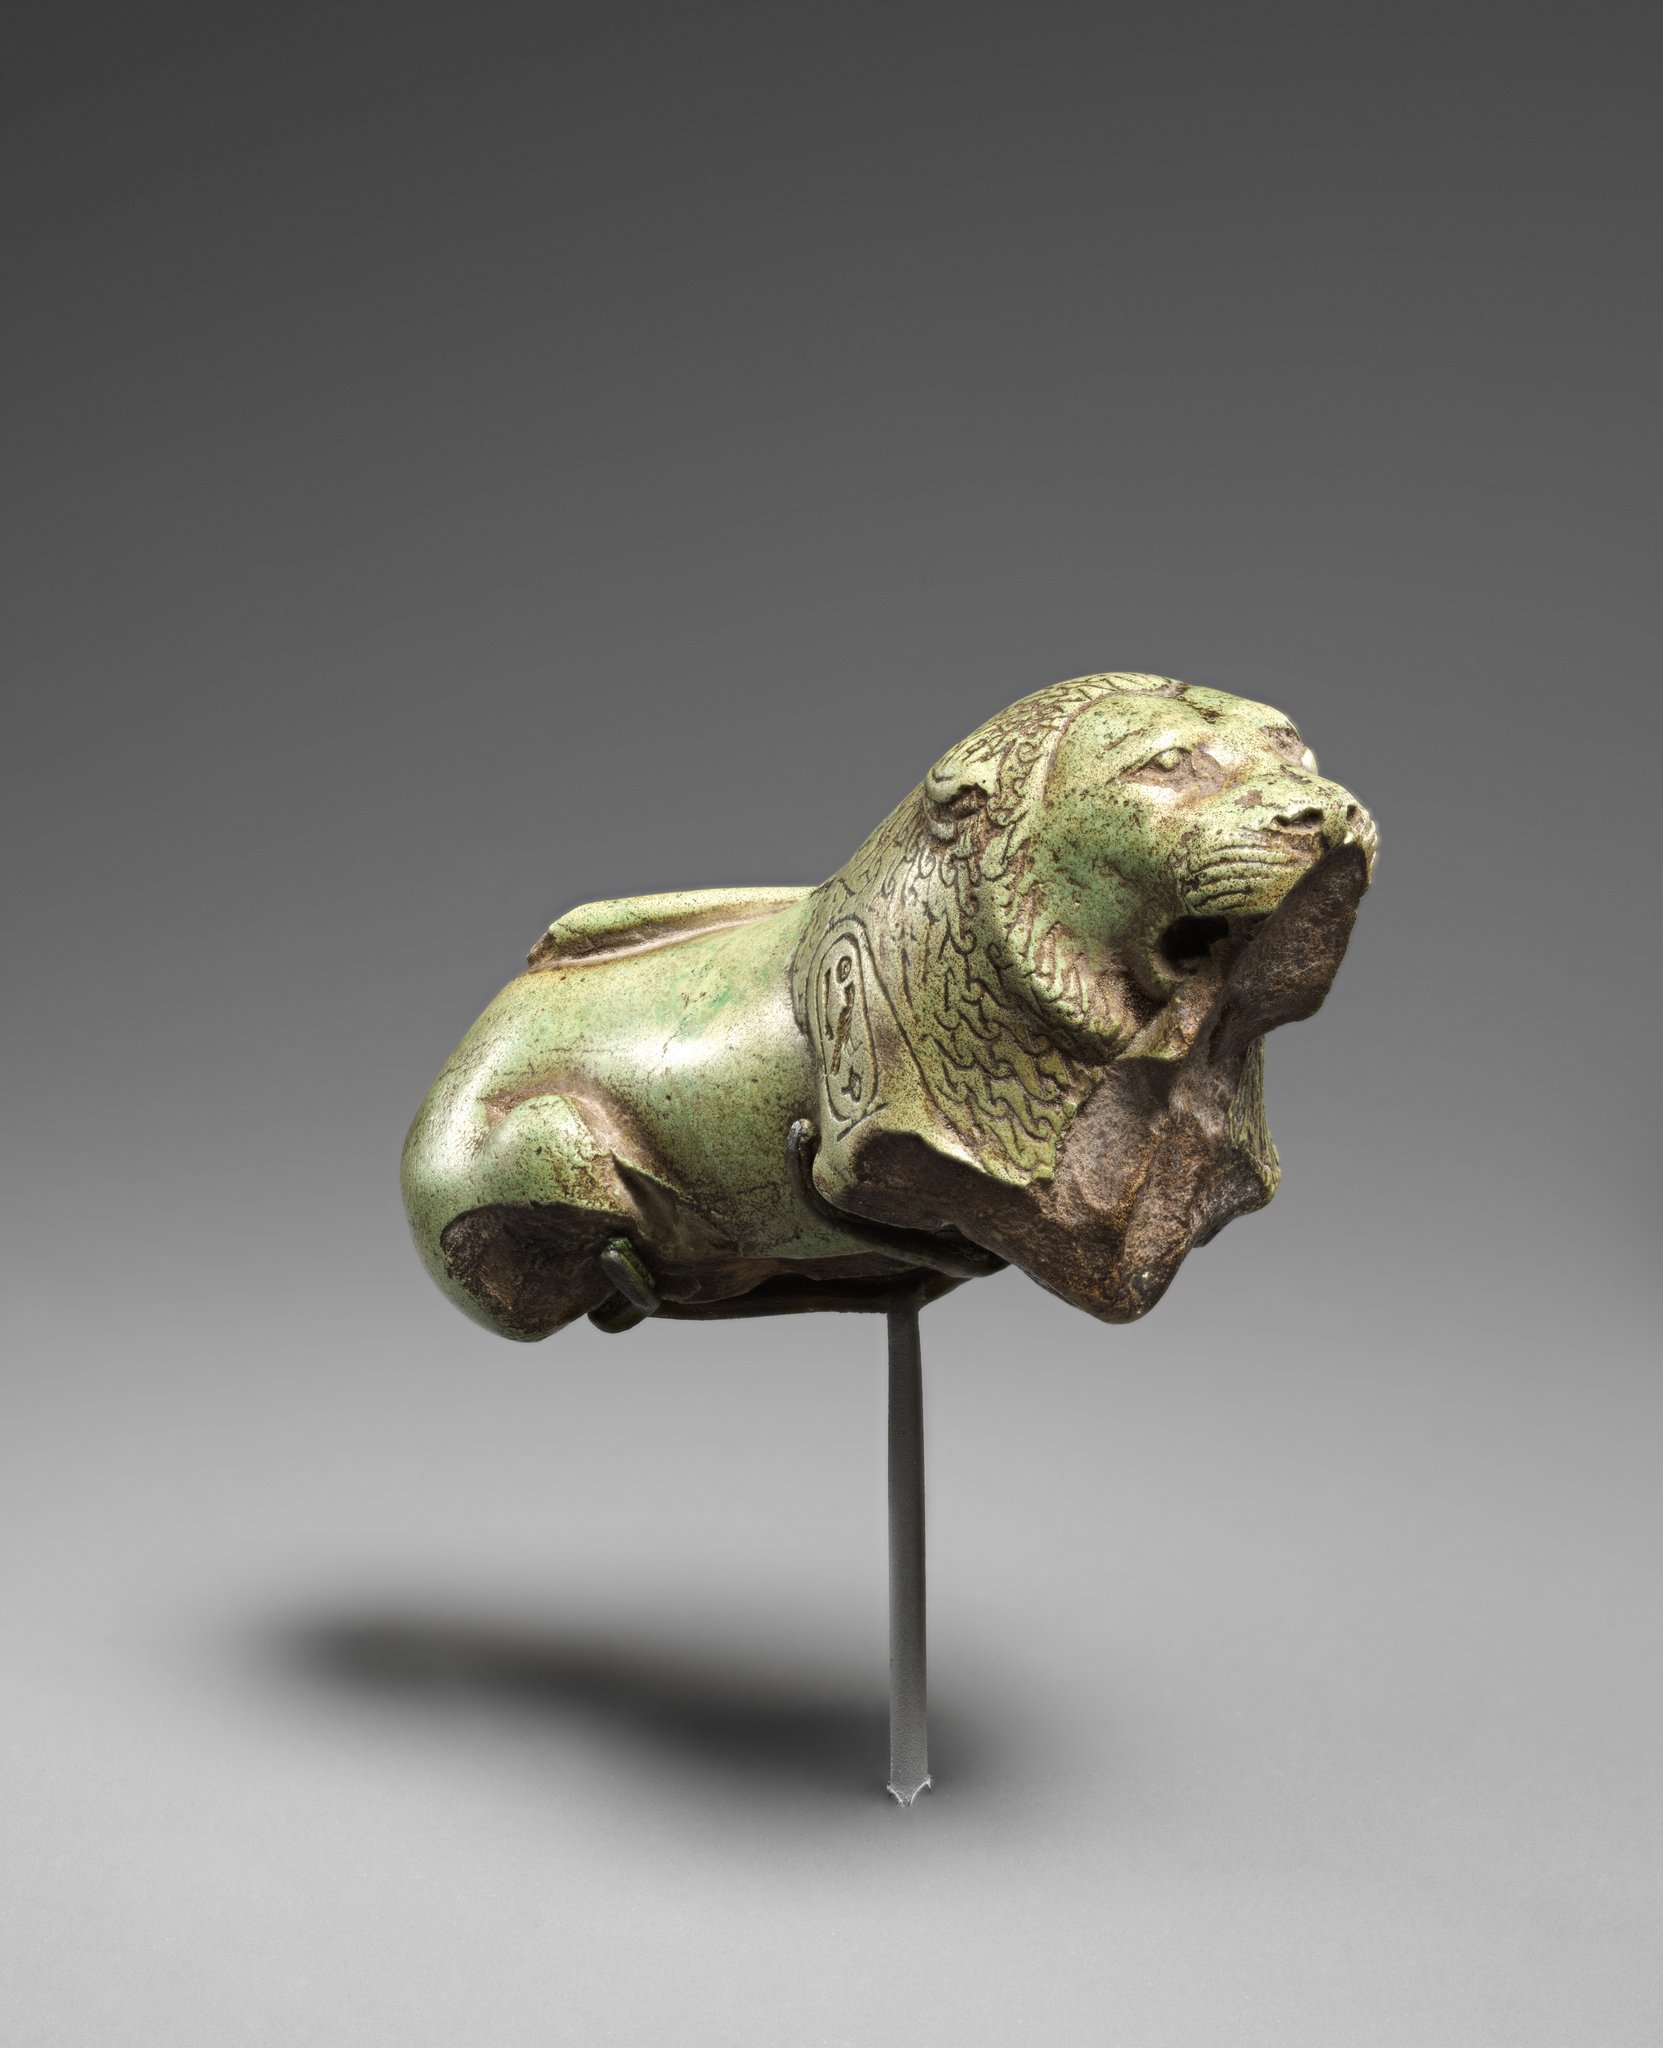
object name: lion, necho ii name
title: Lion with the names of Pharaoh Necho II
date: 610-595 BCE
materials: glaze, stone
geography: egypt